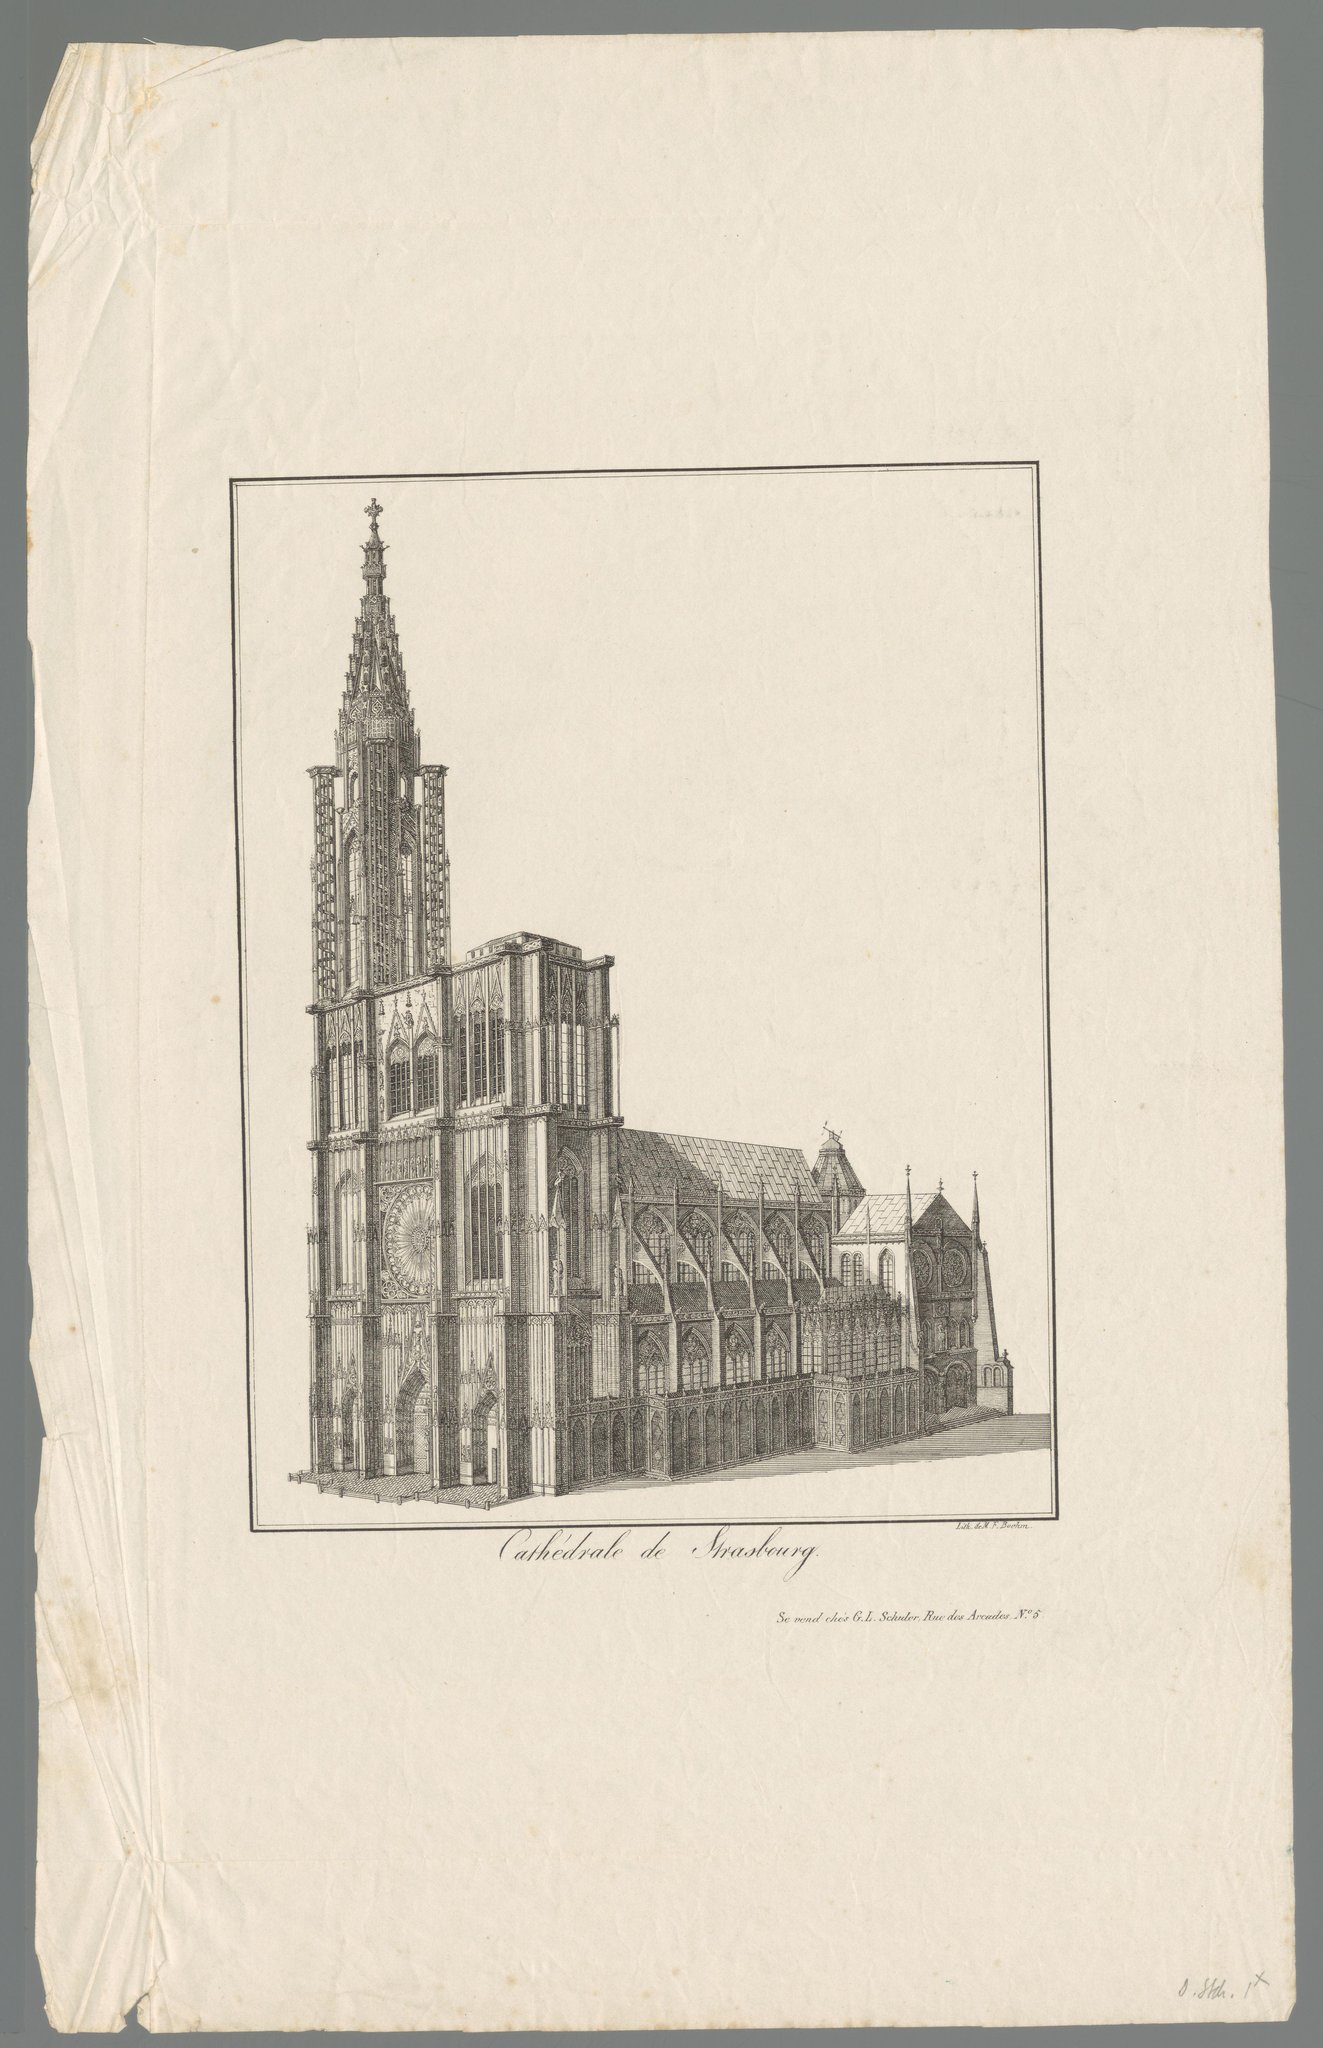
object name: print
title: Kathedraal van Straatsburg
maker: gottlob-louis schuler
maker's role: publisher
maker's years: 1789-1866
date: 1820-1840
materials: paper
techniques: lithograph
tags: church (exterior)